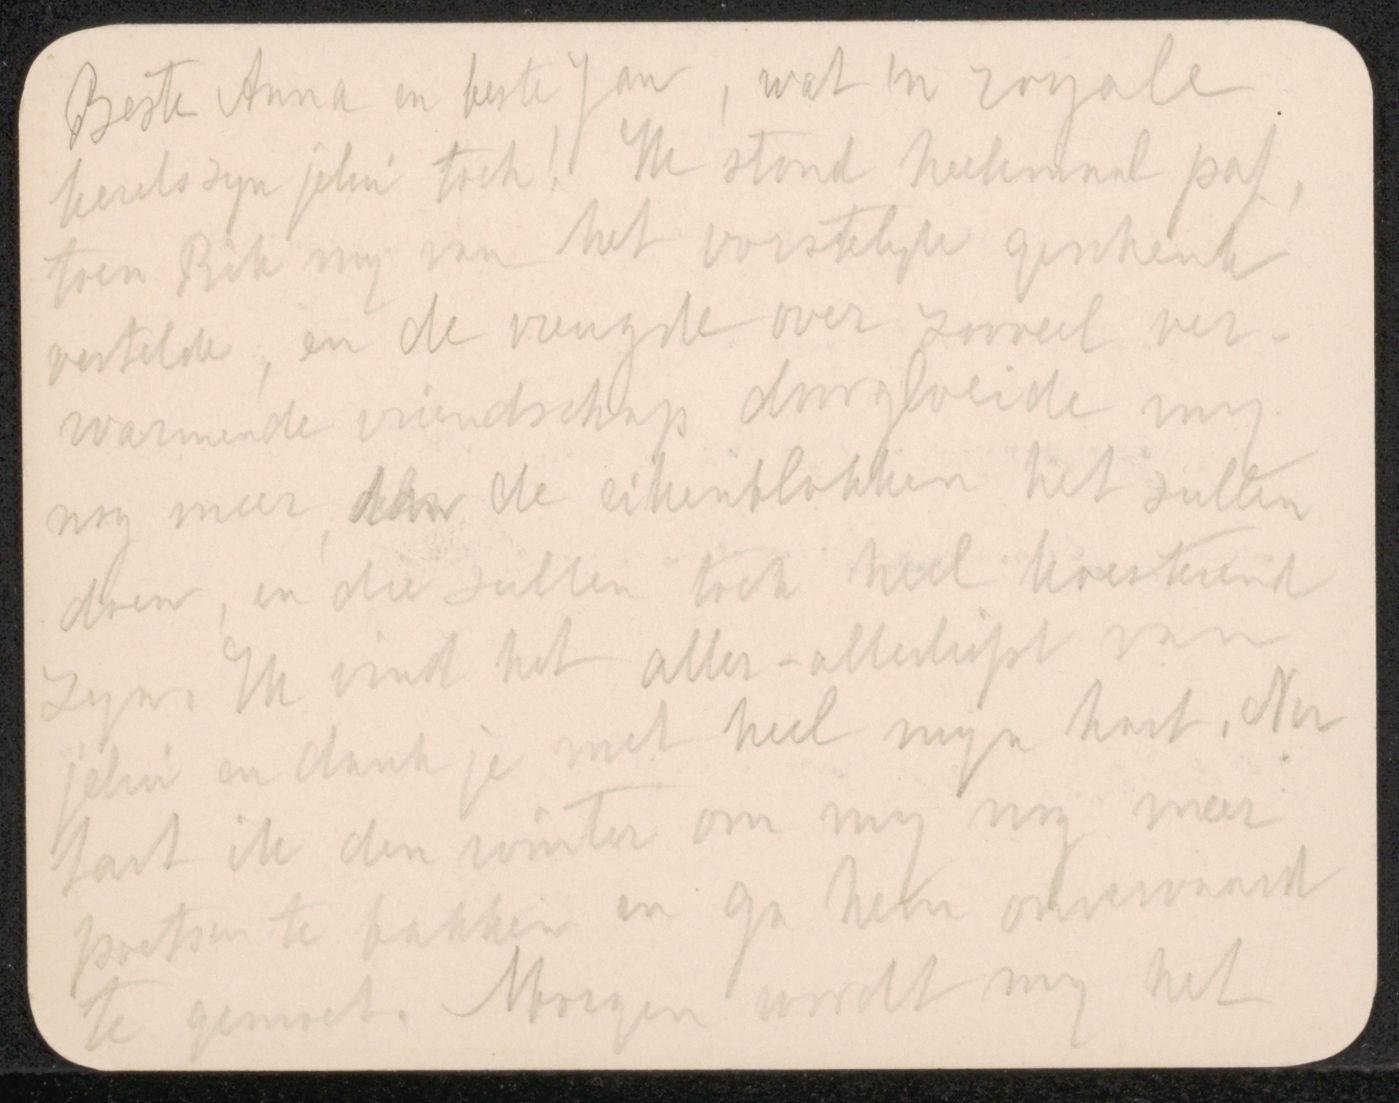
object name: letter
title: Brief aan Anna Dorothea Dirks en Jan Veth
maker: wally moes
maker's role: draughtsman, print maker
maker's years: 1856-1918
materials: paper, pencil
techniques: writing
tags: dordrecht, painter, print maker, draughtsman, designer, jan veth, artist, anna dorothea dirks, richard nicolaüs roland holst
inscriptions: collector's mark: ‘RPK’